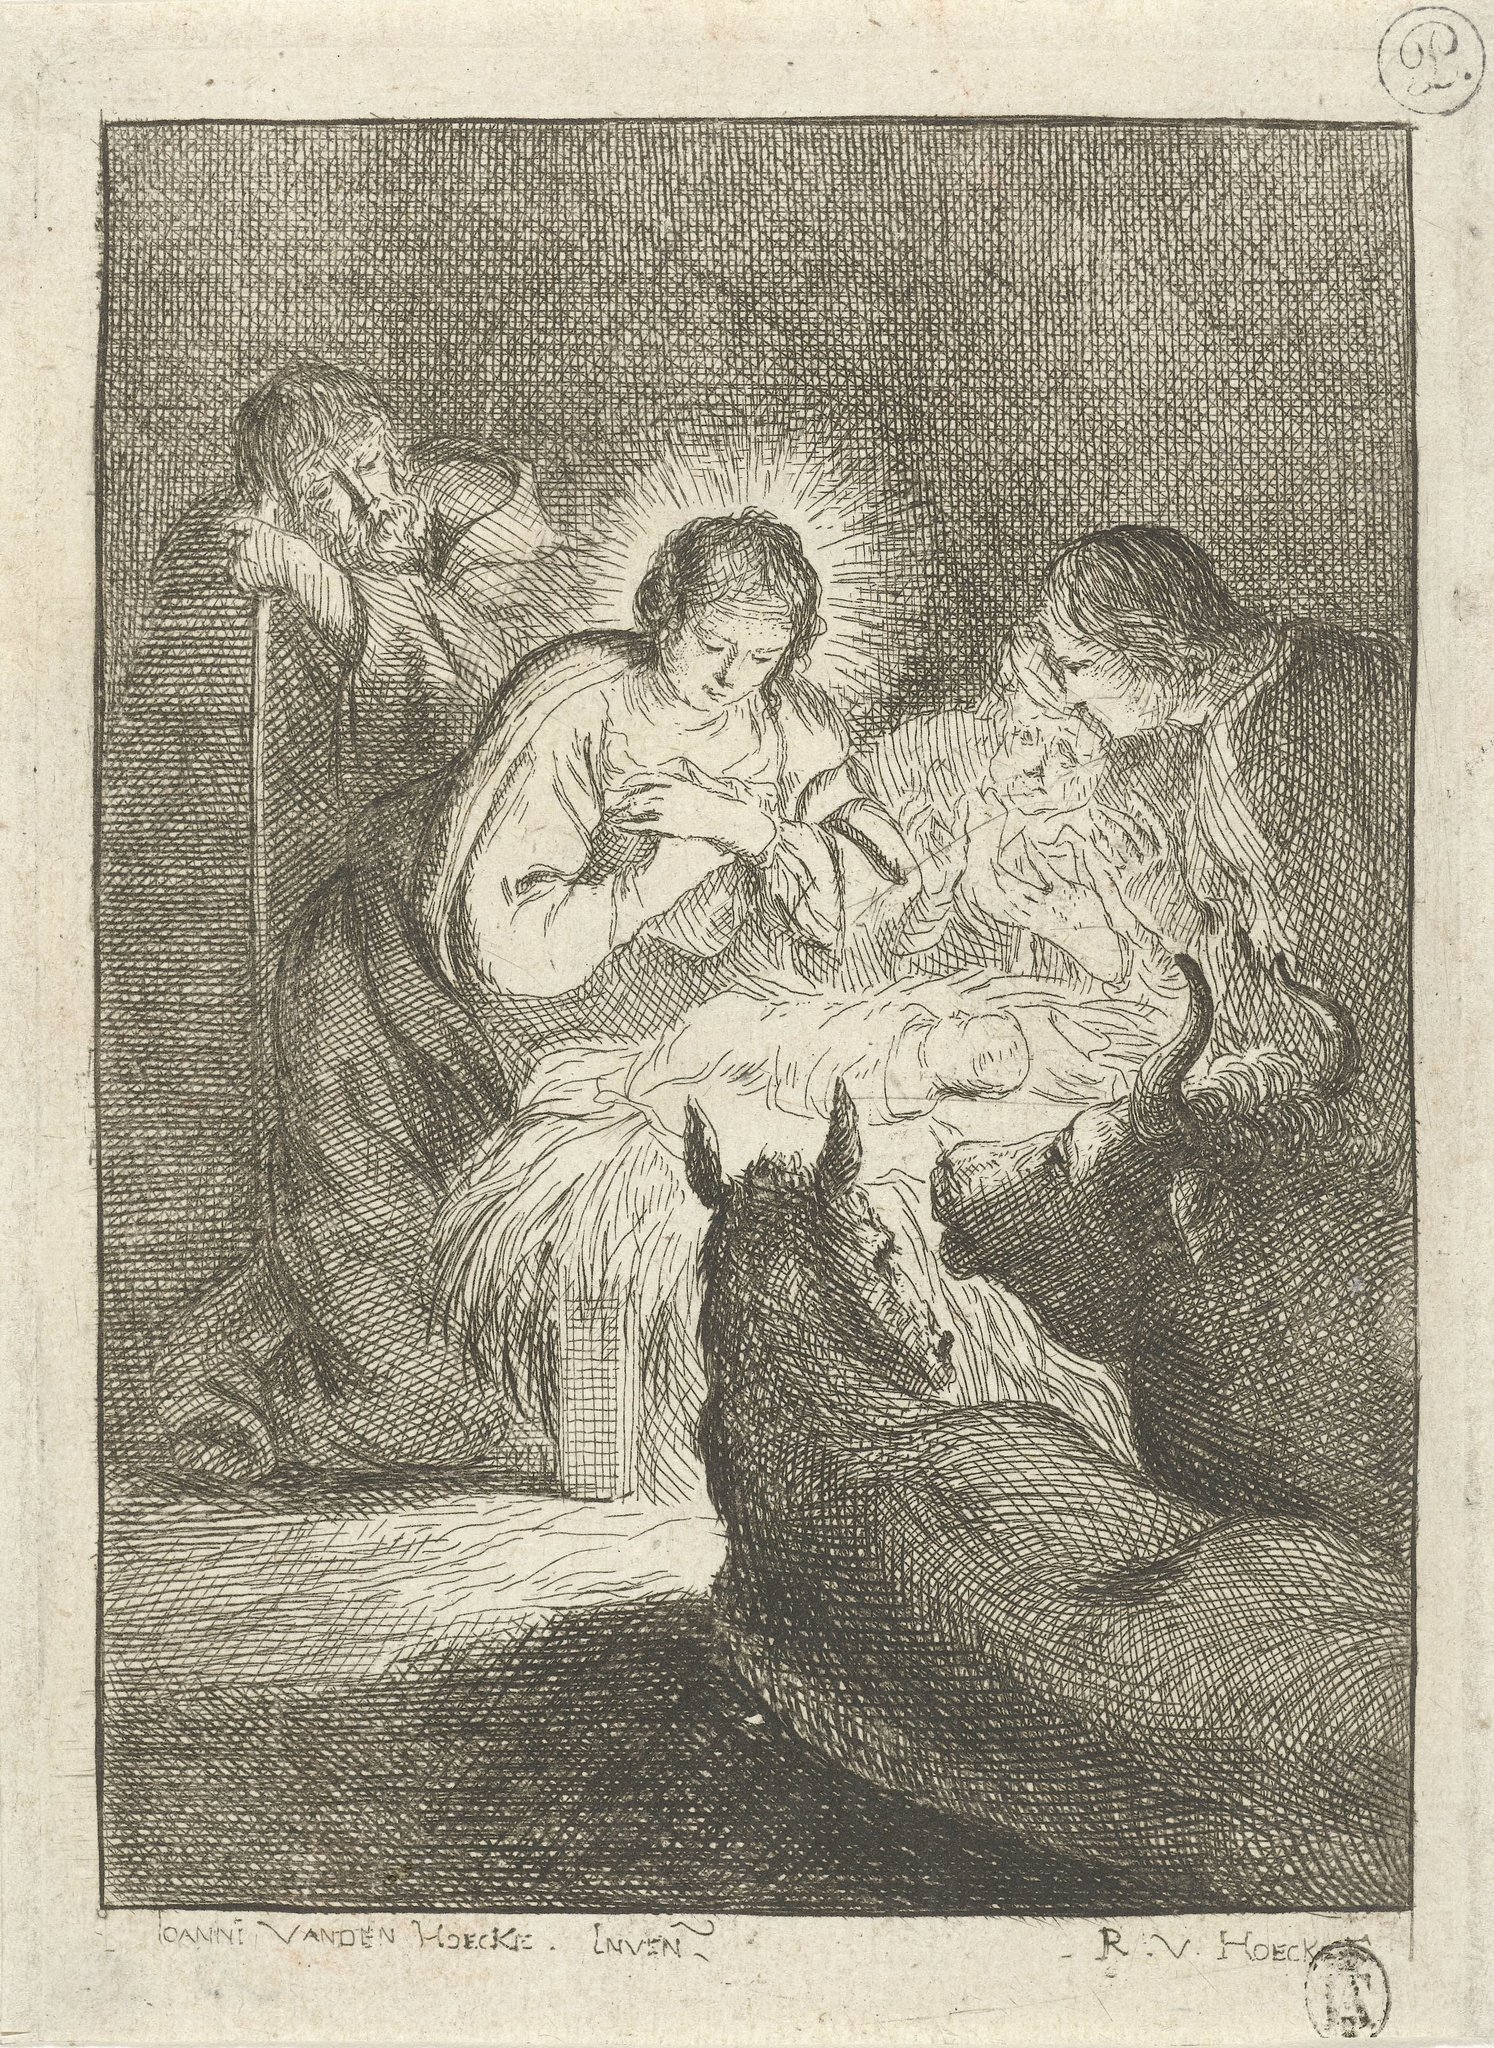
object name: print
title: Geboorte van Christus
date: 1632-1668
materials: paper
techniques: etching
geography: southern netherlands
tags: adoration of the christ-child ~ christ's birth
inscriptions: collector's mark: Lugt 971, collector's mark: Lugt 2064